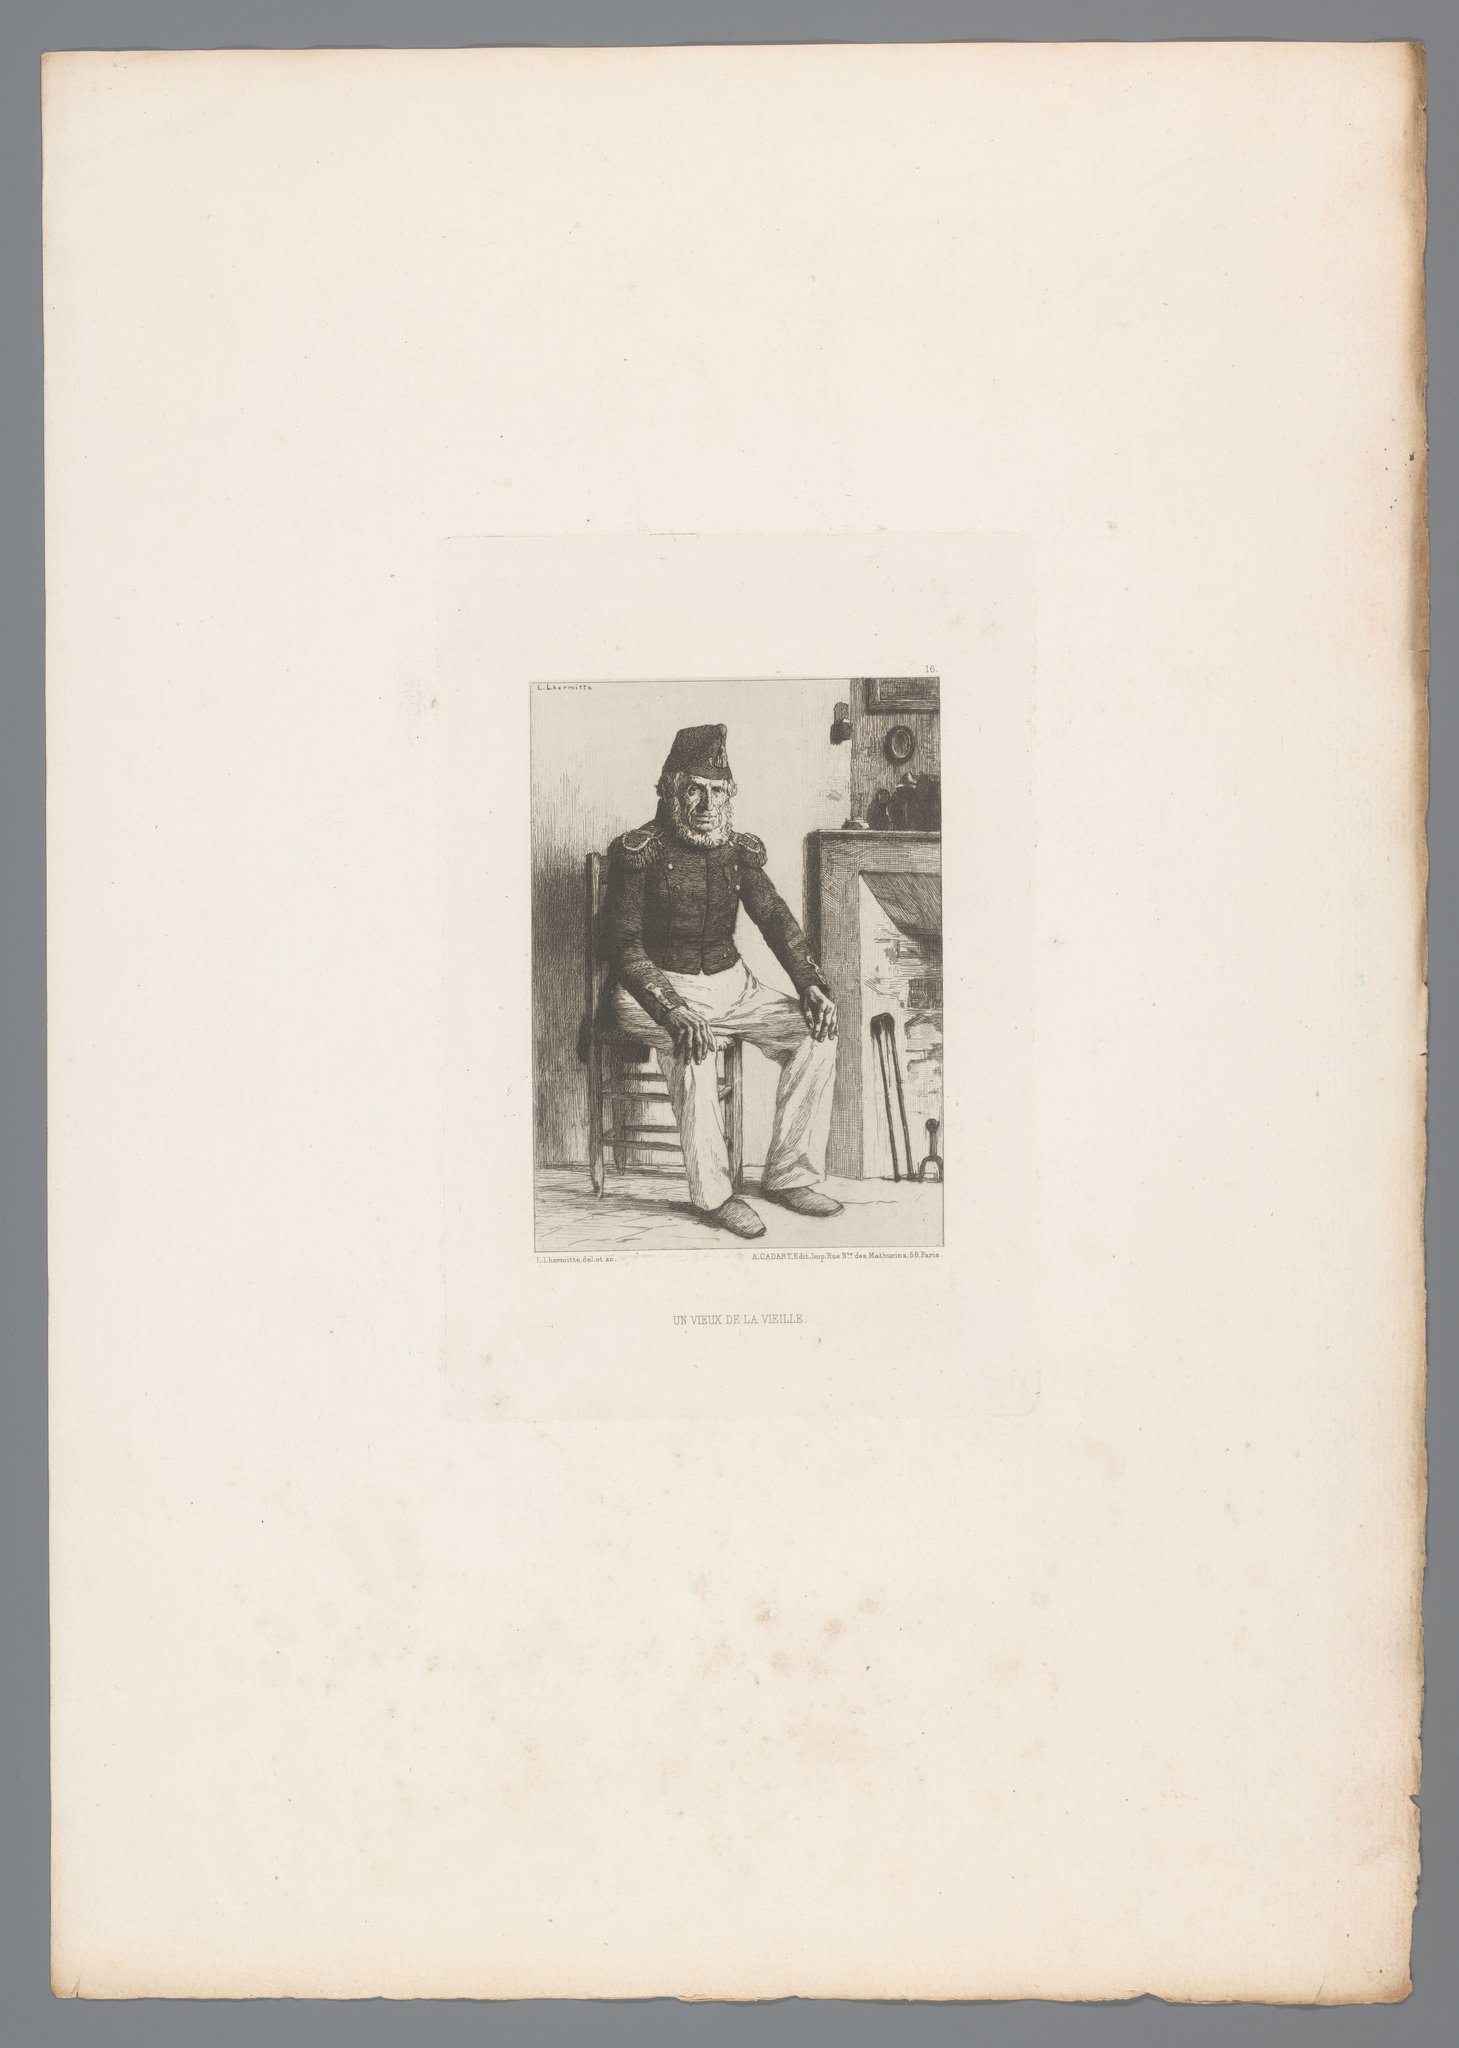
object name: print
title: Oude man met baard op een stoel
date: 1874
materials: paper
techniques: drypoint, etching, intaglio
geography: paris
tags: sitting figure, open hearth, fire-place, old man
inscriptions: collector's mark: Lugt 2228, collector's mark: ‘AFE v S’, watermark, collector's mark: Lugt 2760